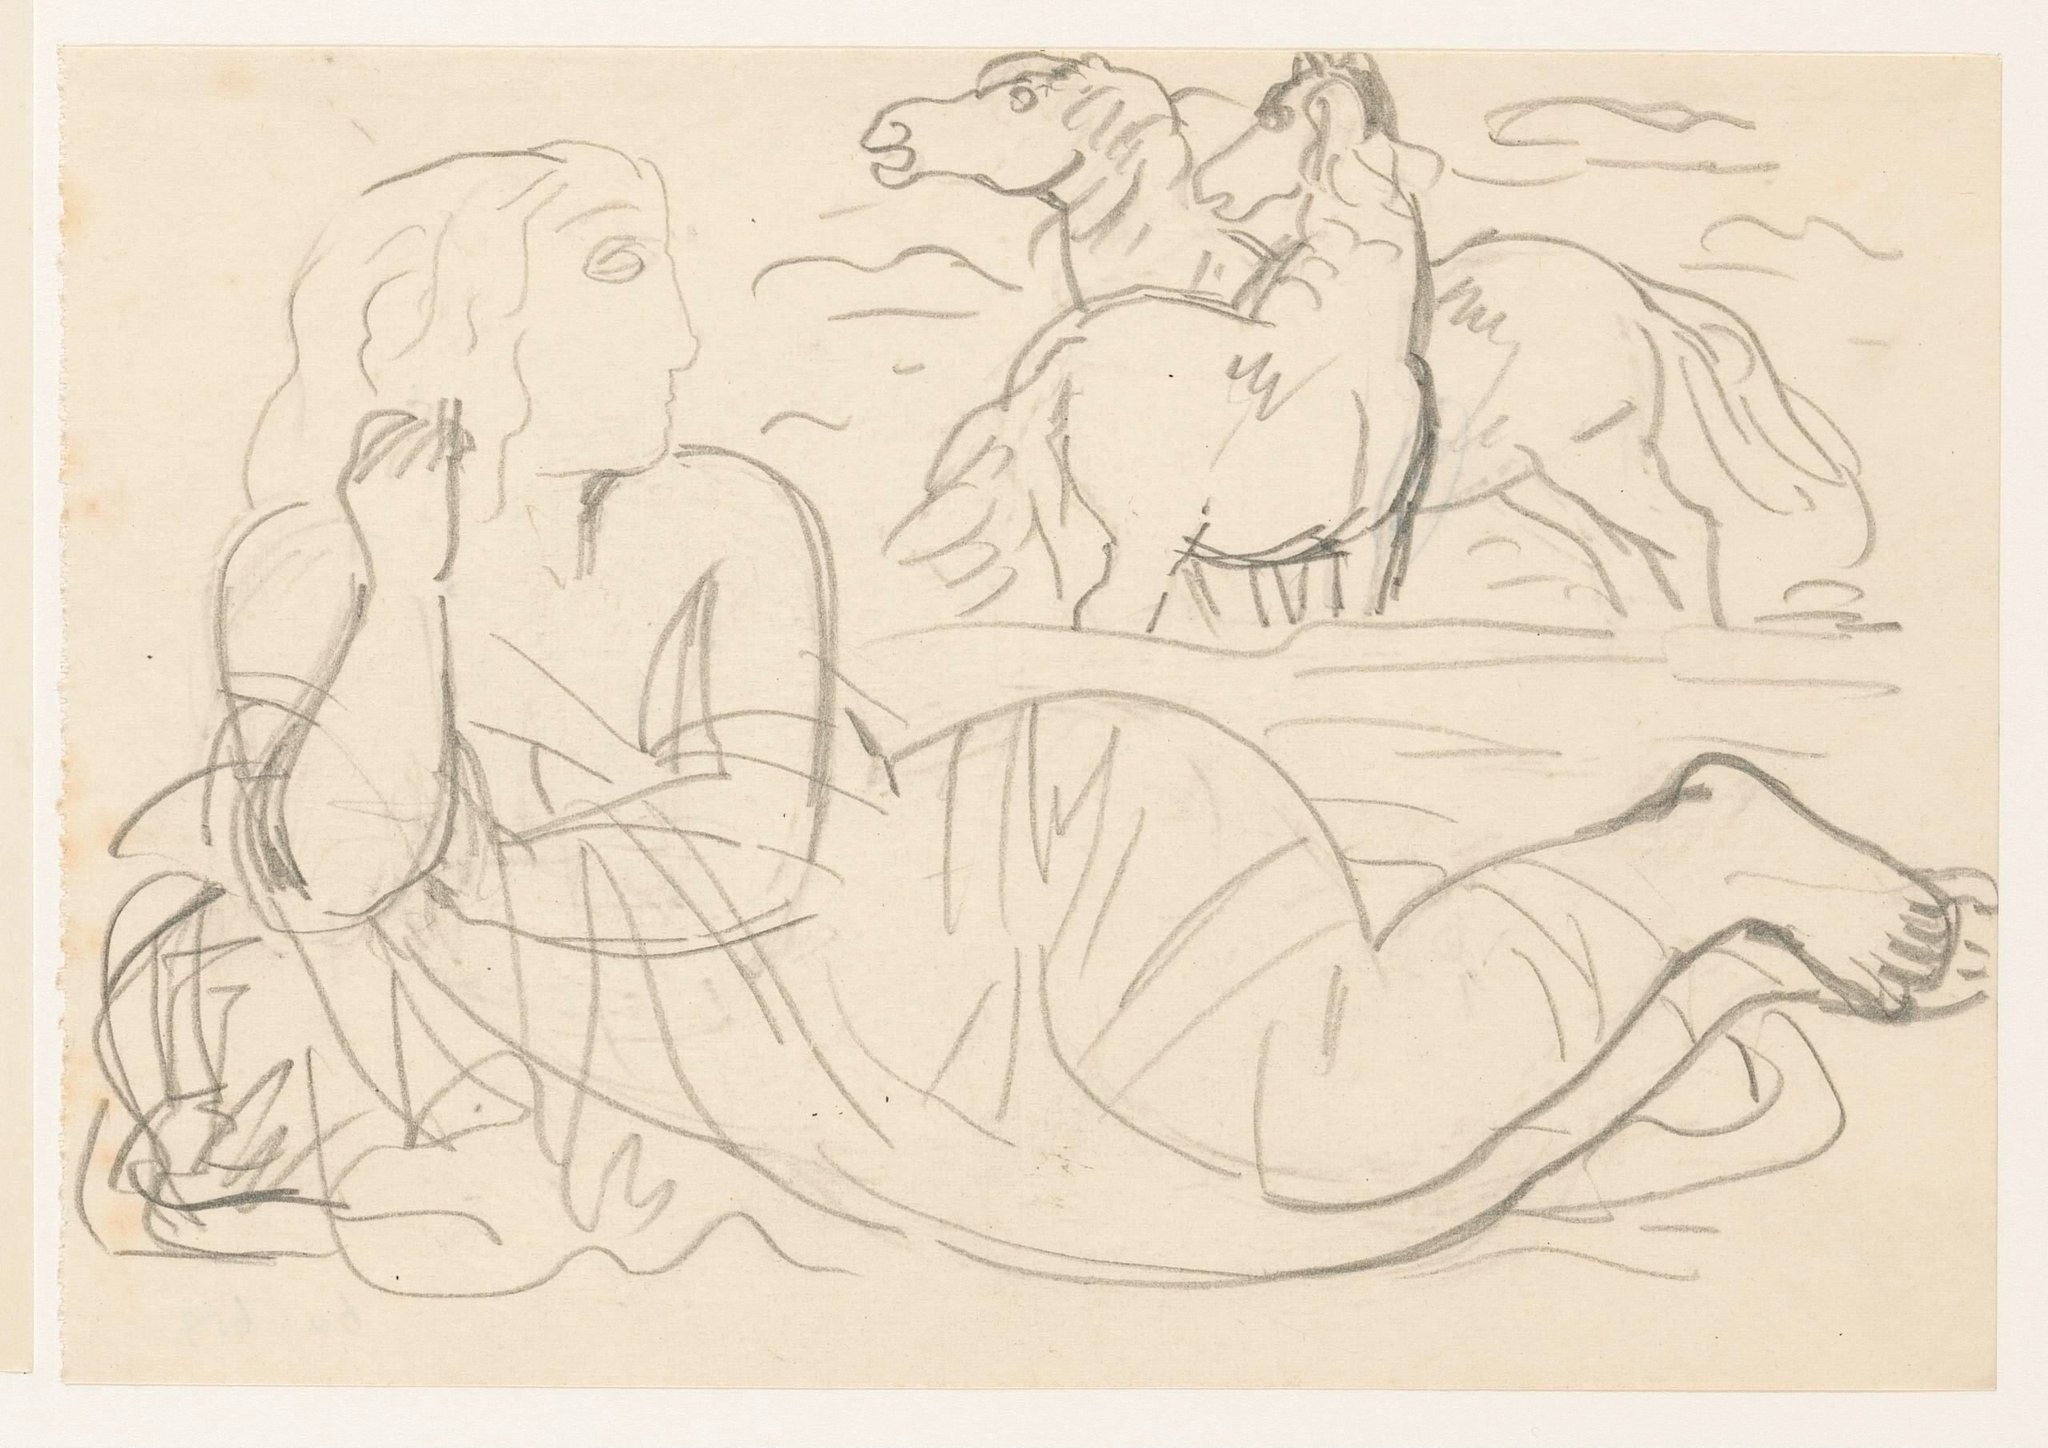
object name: drawing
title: Liggende vrouw, met op de achtergrond twee paarden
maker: leo gestel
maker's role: draughtsman, print maker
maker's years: 1881-1941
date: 1891-1941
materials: paper, pencil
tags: lying on one side, with uplifted upper part of the body and leaning on the arm - aa - female human figure, horse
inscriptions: collector's mark: Lugt 2228